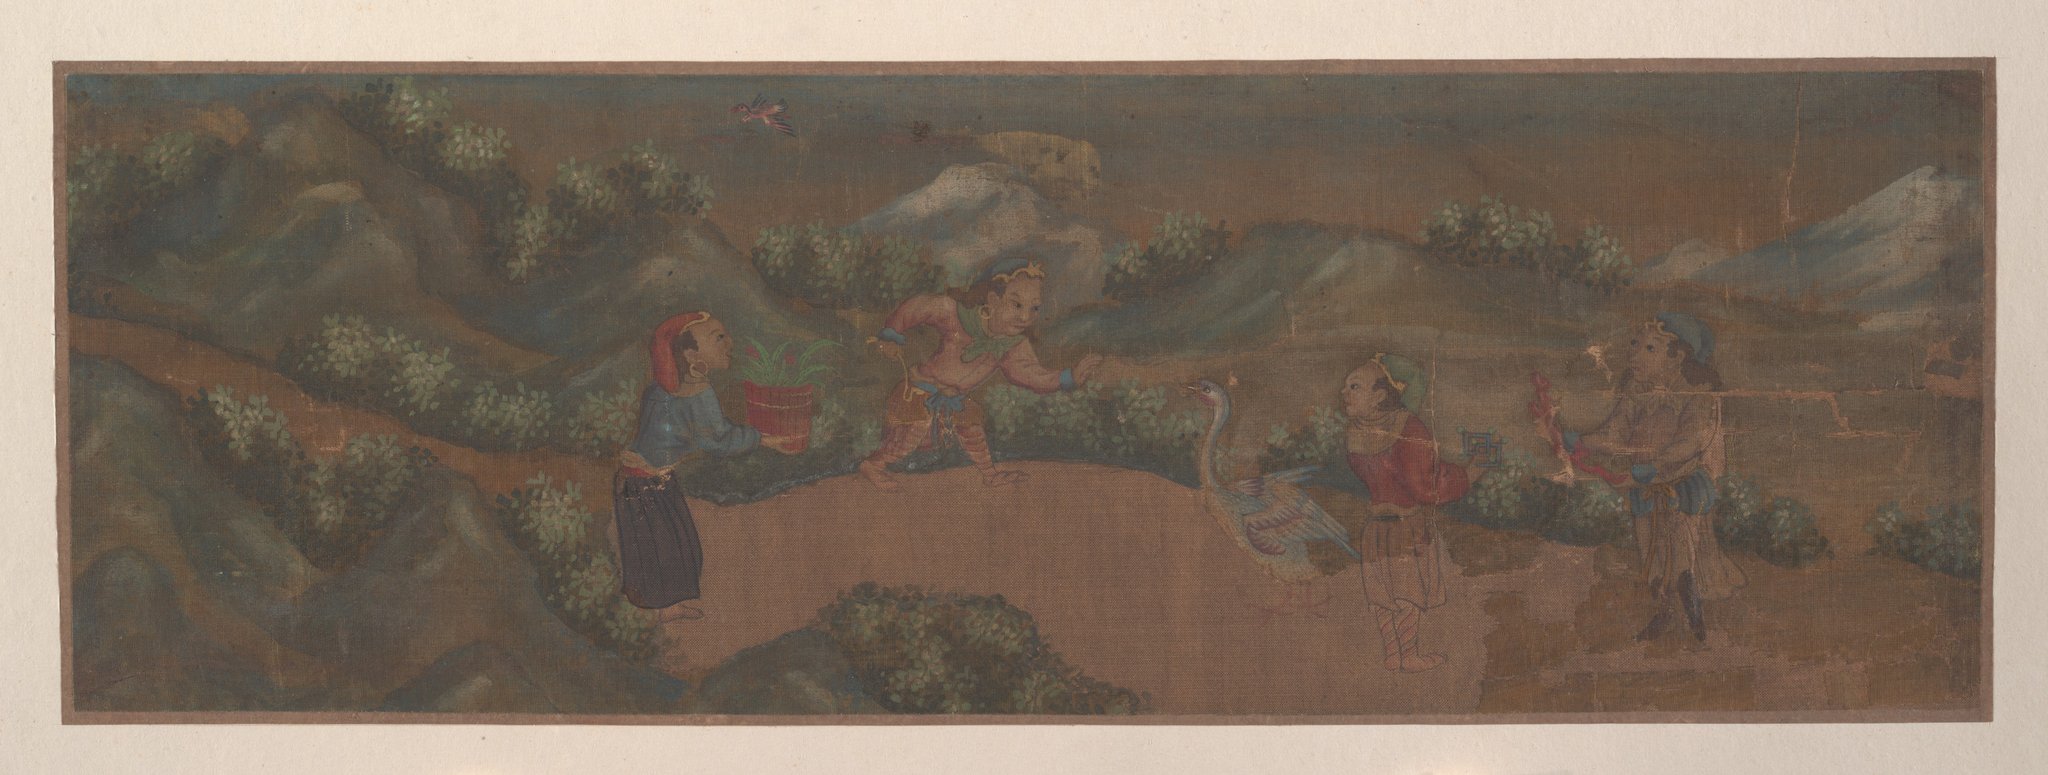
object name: album leaf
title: Landscape Painting of Figure in Woodland Setting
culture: chinese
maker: unidentified artist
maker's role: artist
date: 1644-1911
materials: silk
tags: birds,men,women,forests